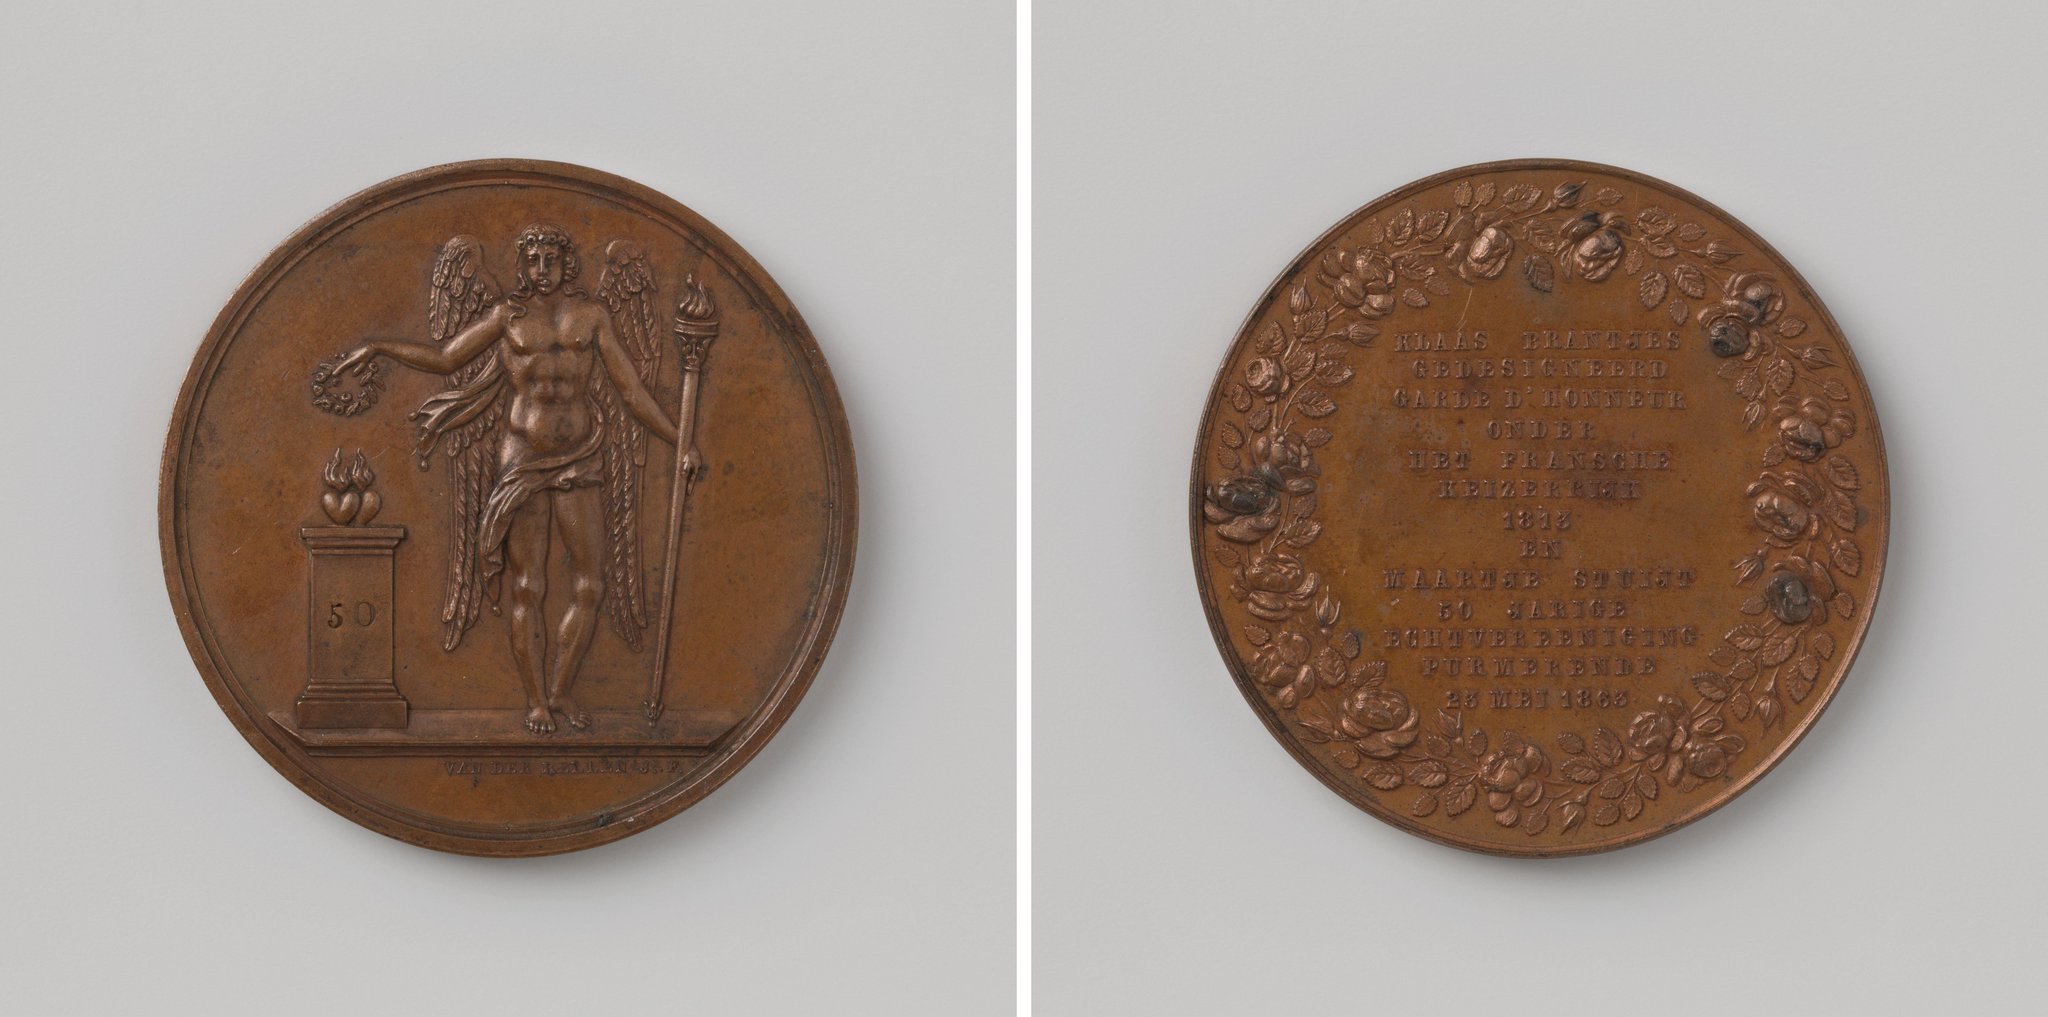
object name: marriage medal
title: Vijftigjarig huwelijk van Klaas Brantjes, lid van de Garde d'Honneur onder het Franse keizerrijk en Maartje Stuijt te Purmerend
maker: david van der kellen (1804-1879)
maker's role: die cutter, draughtsman, print maker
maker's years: 1804-1879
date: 1863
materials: bronze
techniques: engraving, striking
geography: utrecht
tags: klaas brantjes, maartje stuijt, purmerend, napoleontische oorlogen